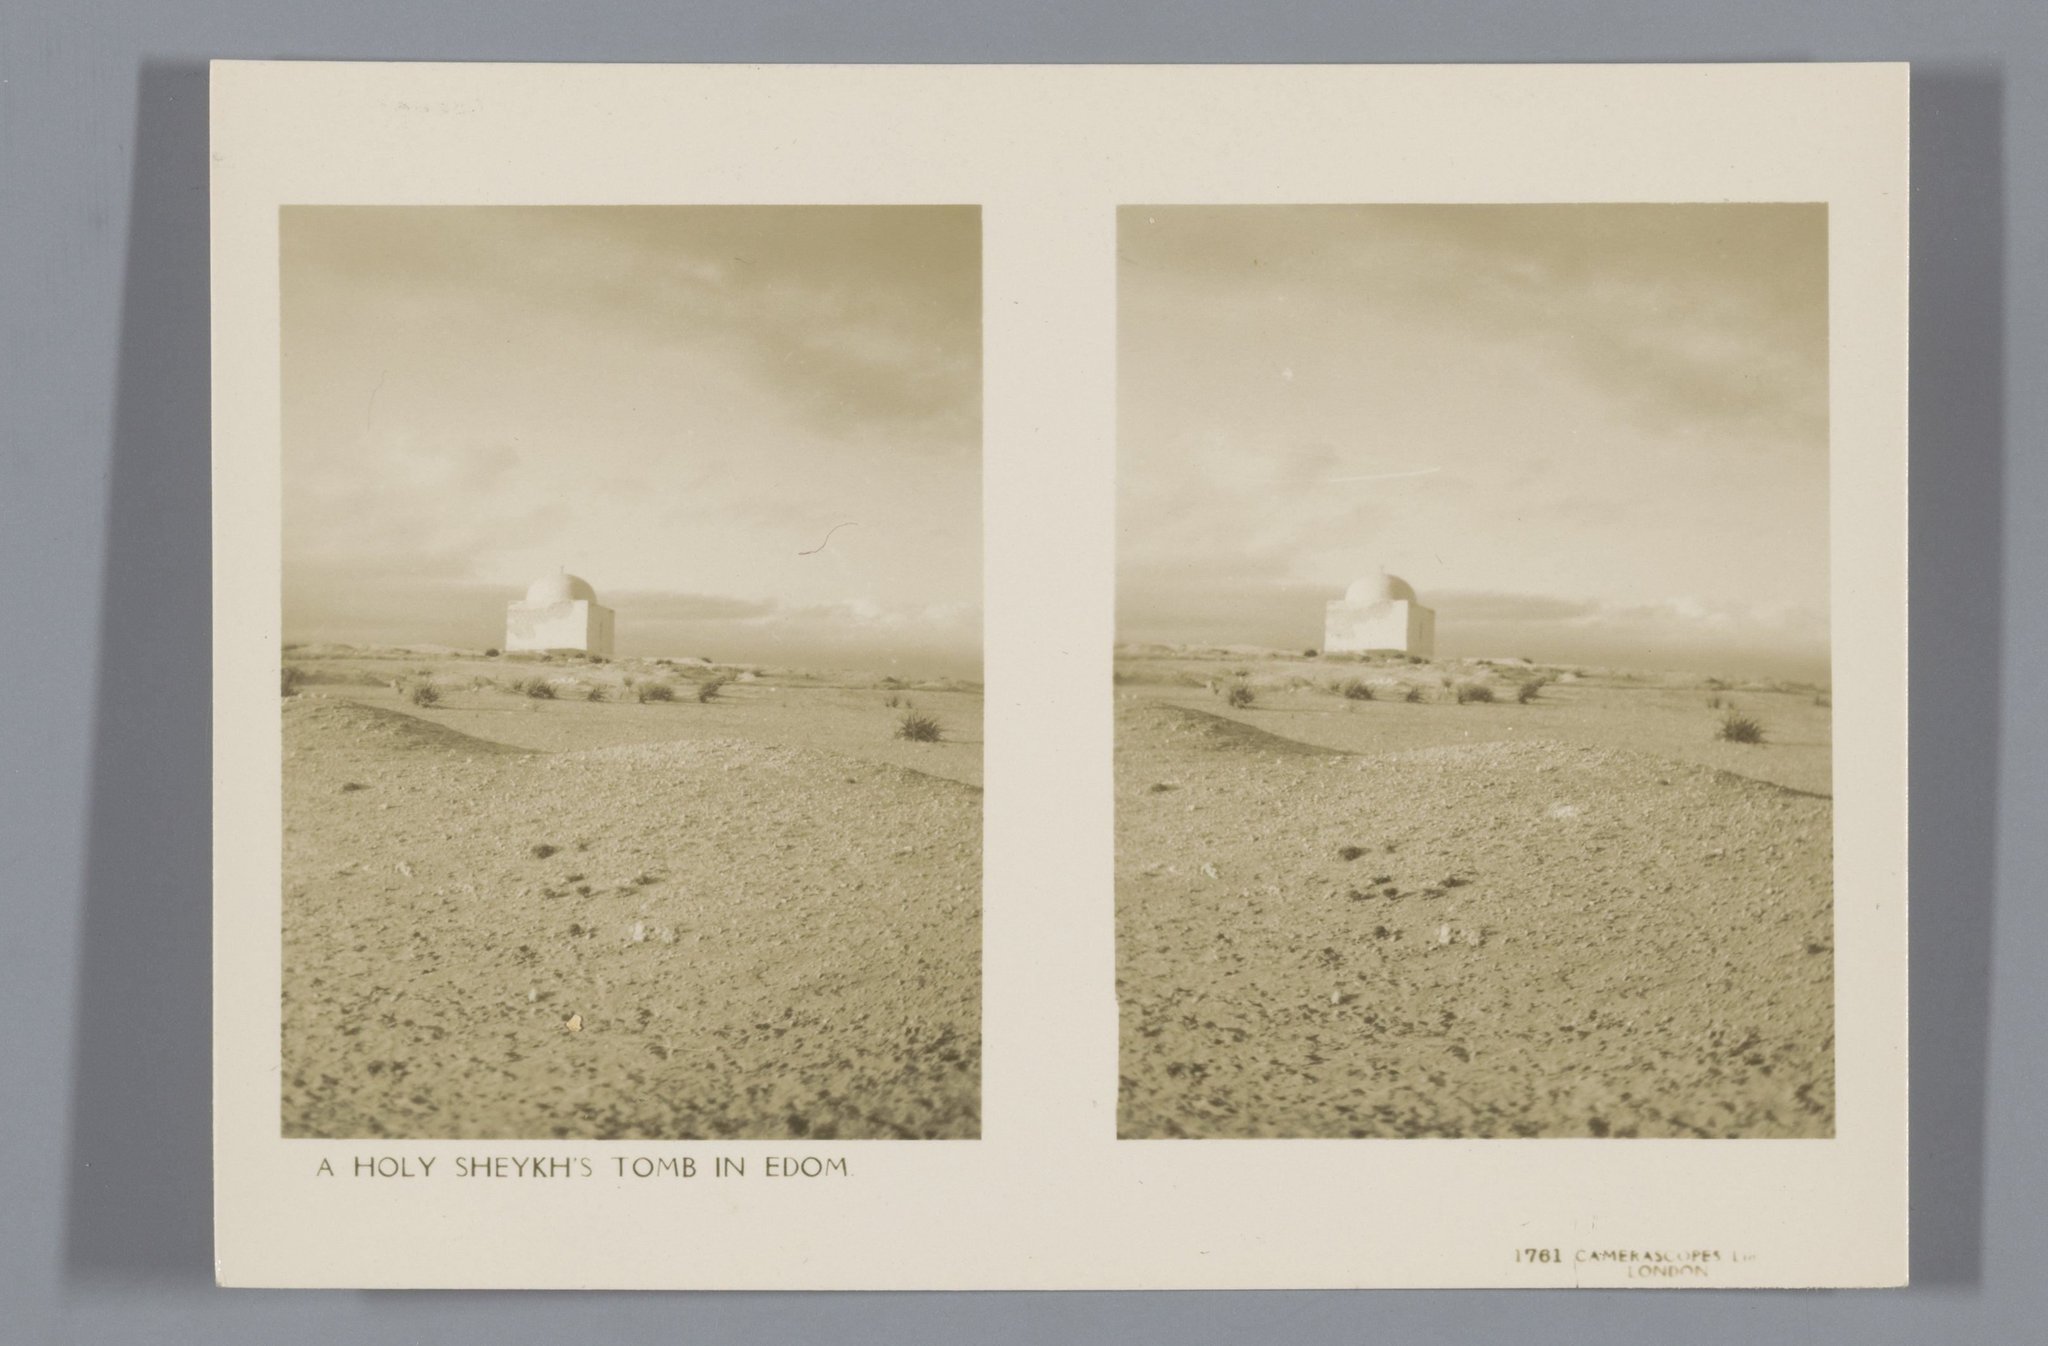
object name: stereograph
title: A Holy Sheykh's Tomb in Edom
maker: richard st. barbe baker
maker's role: activist, bioloog, botanicus, fotograaf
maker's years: 1889-1982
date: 1902-1929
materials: paper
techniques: gelatin silver print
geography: london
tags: grave, tomb, desert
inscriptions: number: ‘1761’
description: Serie over de opgravingen van de Britse archeologen Gerald Harding en Flinders Petrie bij Tell Fara in het toenmalige Brits Mandaatgebied Palestina.